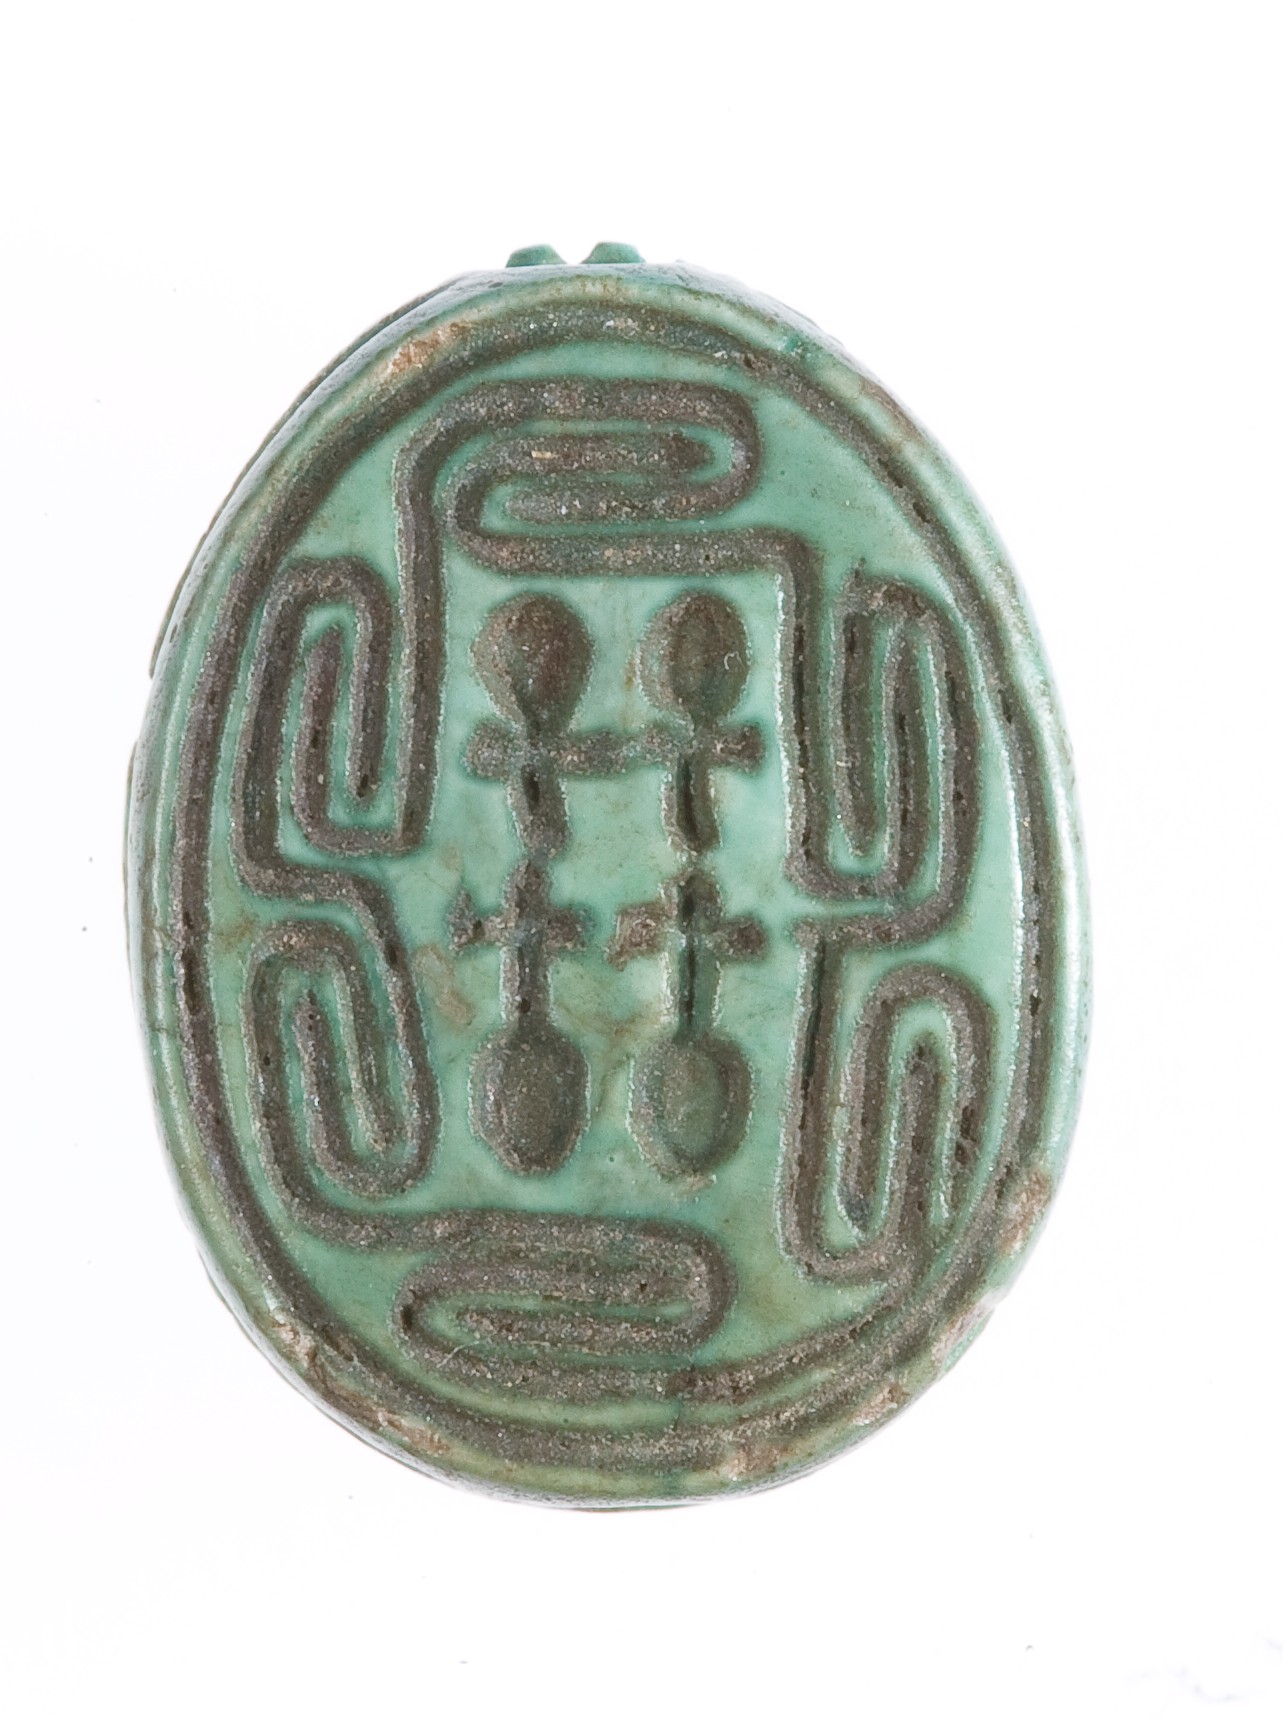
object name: scarab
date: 1550-1458 BCE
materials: stone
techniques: glazing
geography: egypt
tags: scarabs